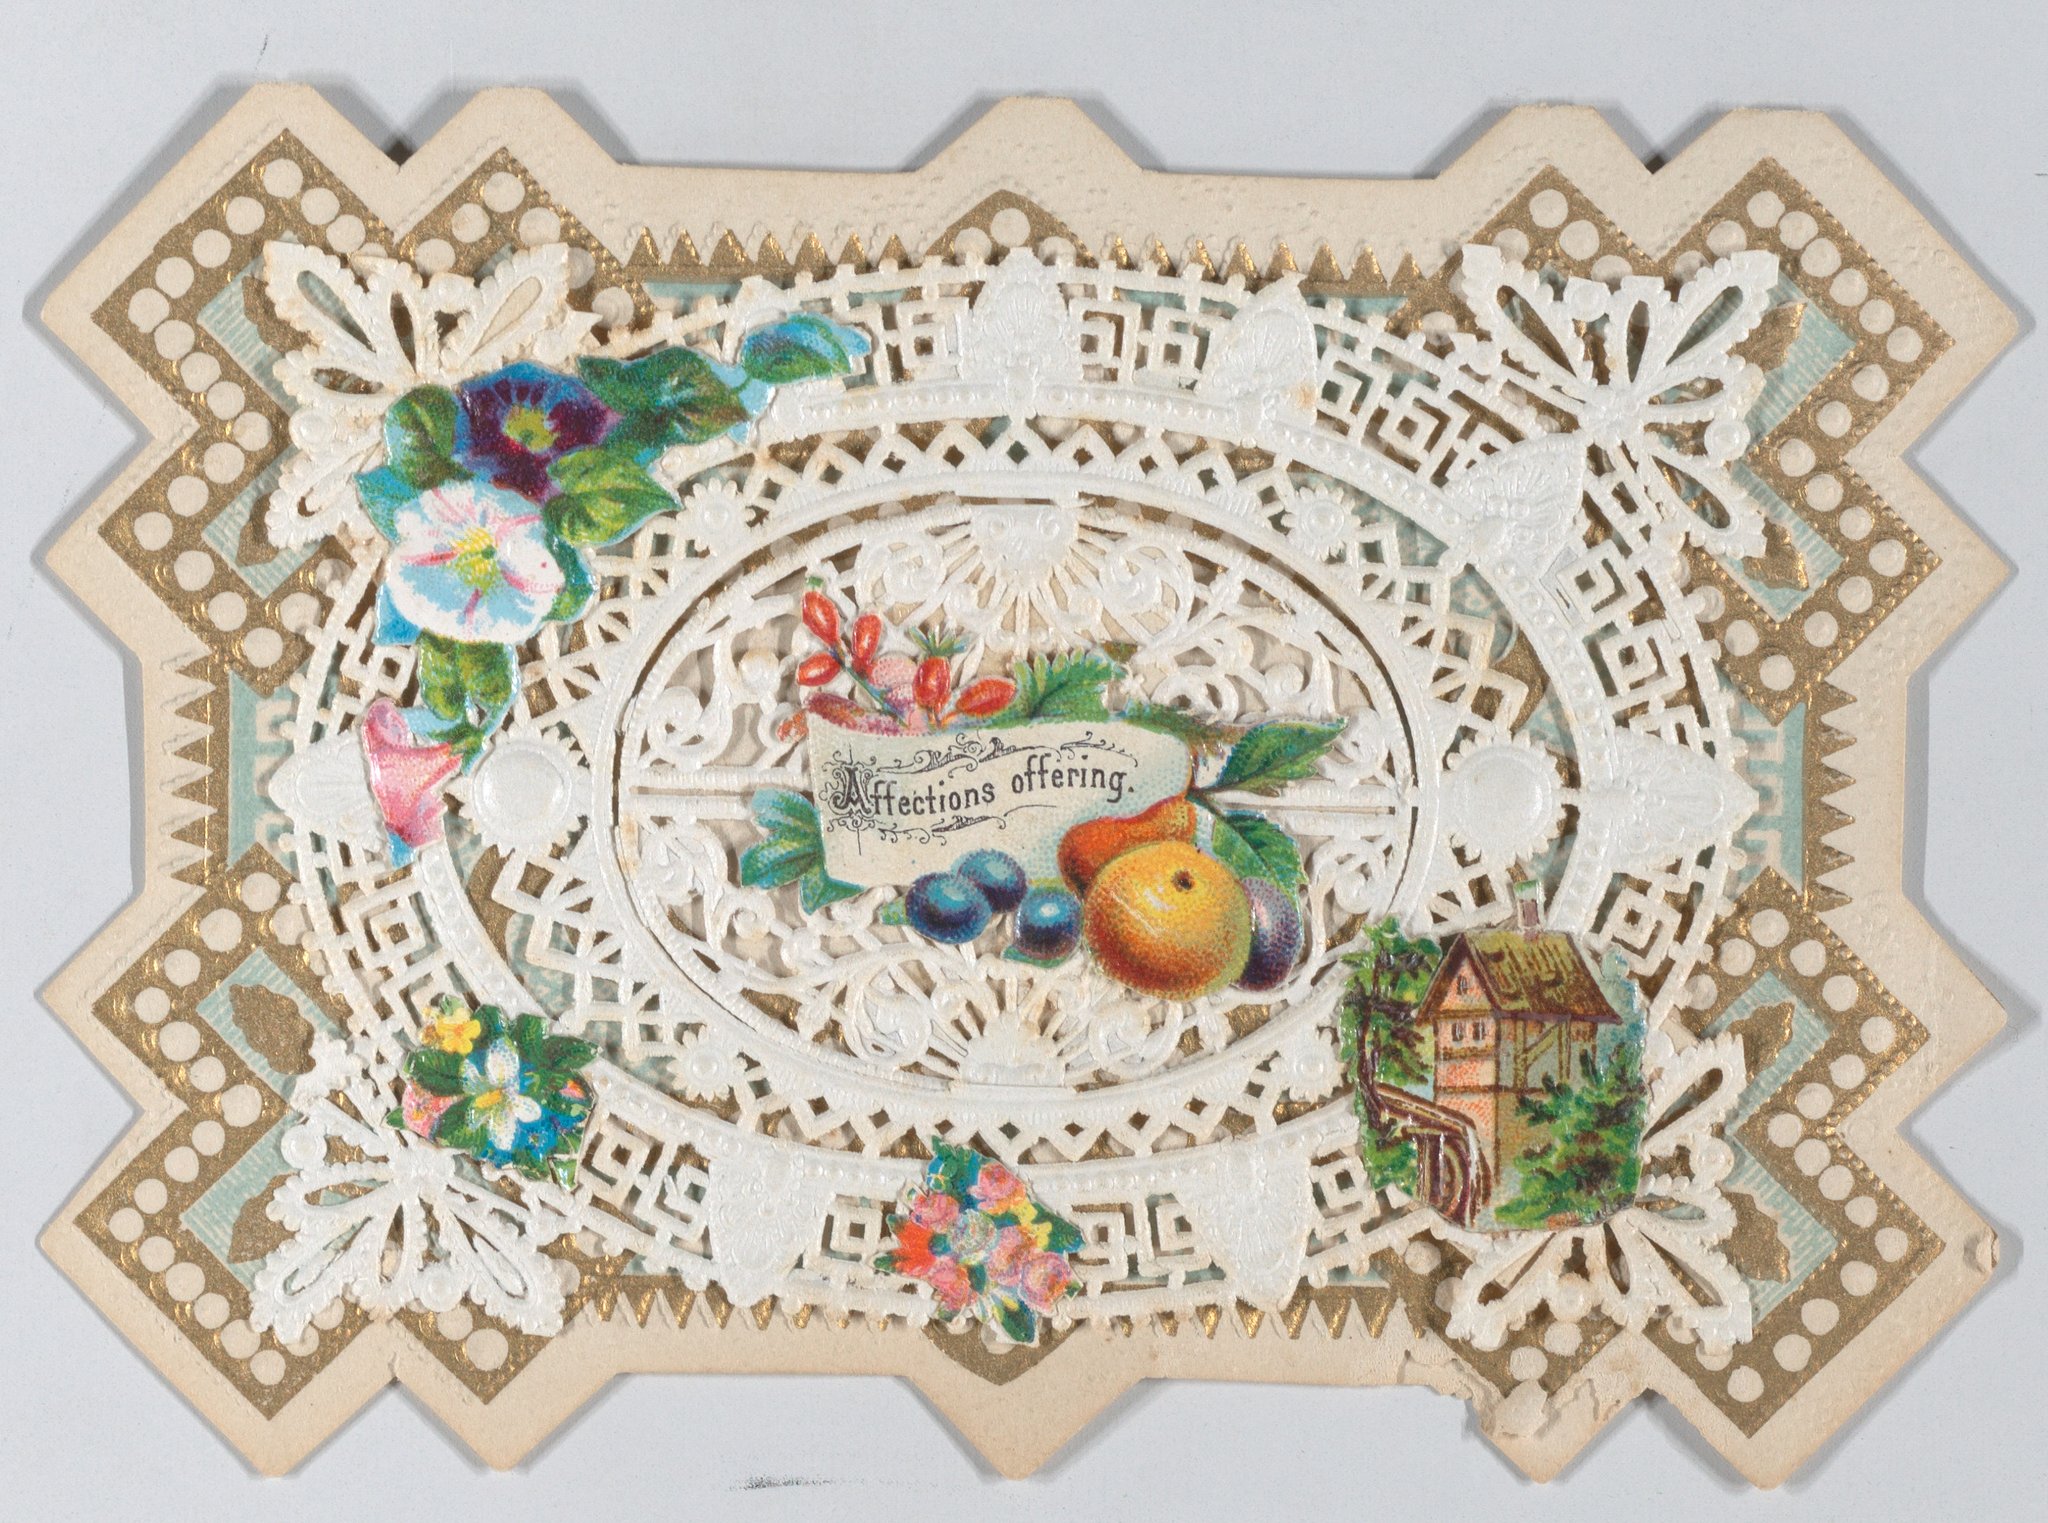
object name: valentine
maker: Anonymous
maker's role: artist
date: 1880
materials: graphite, ink, paper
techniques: chromolithography, embossing